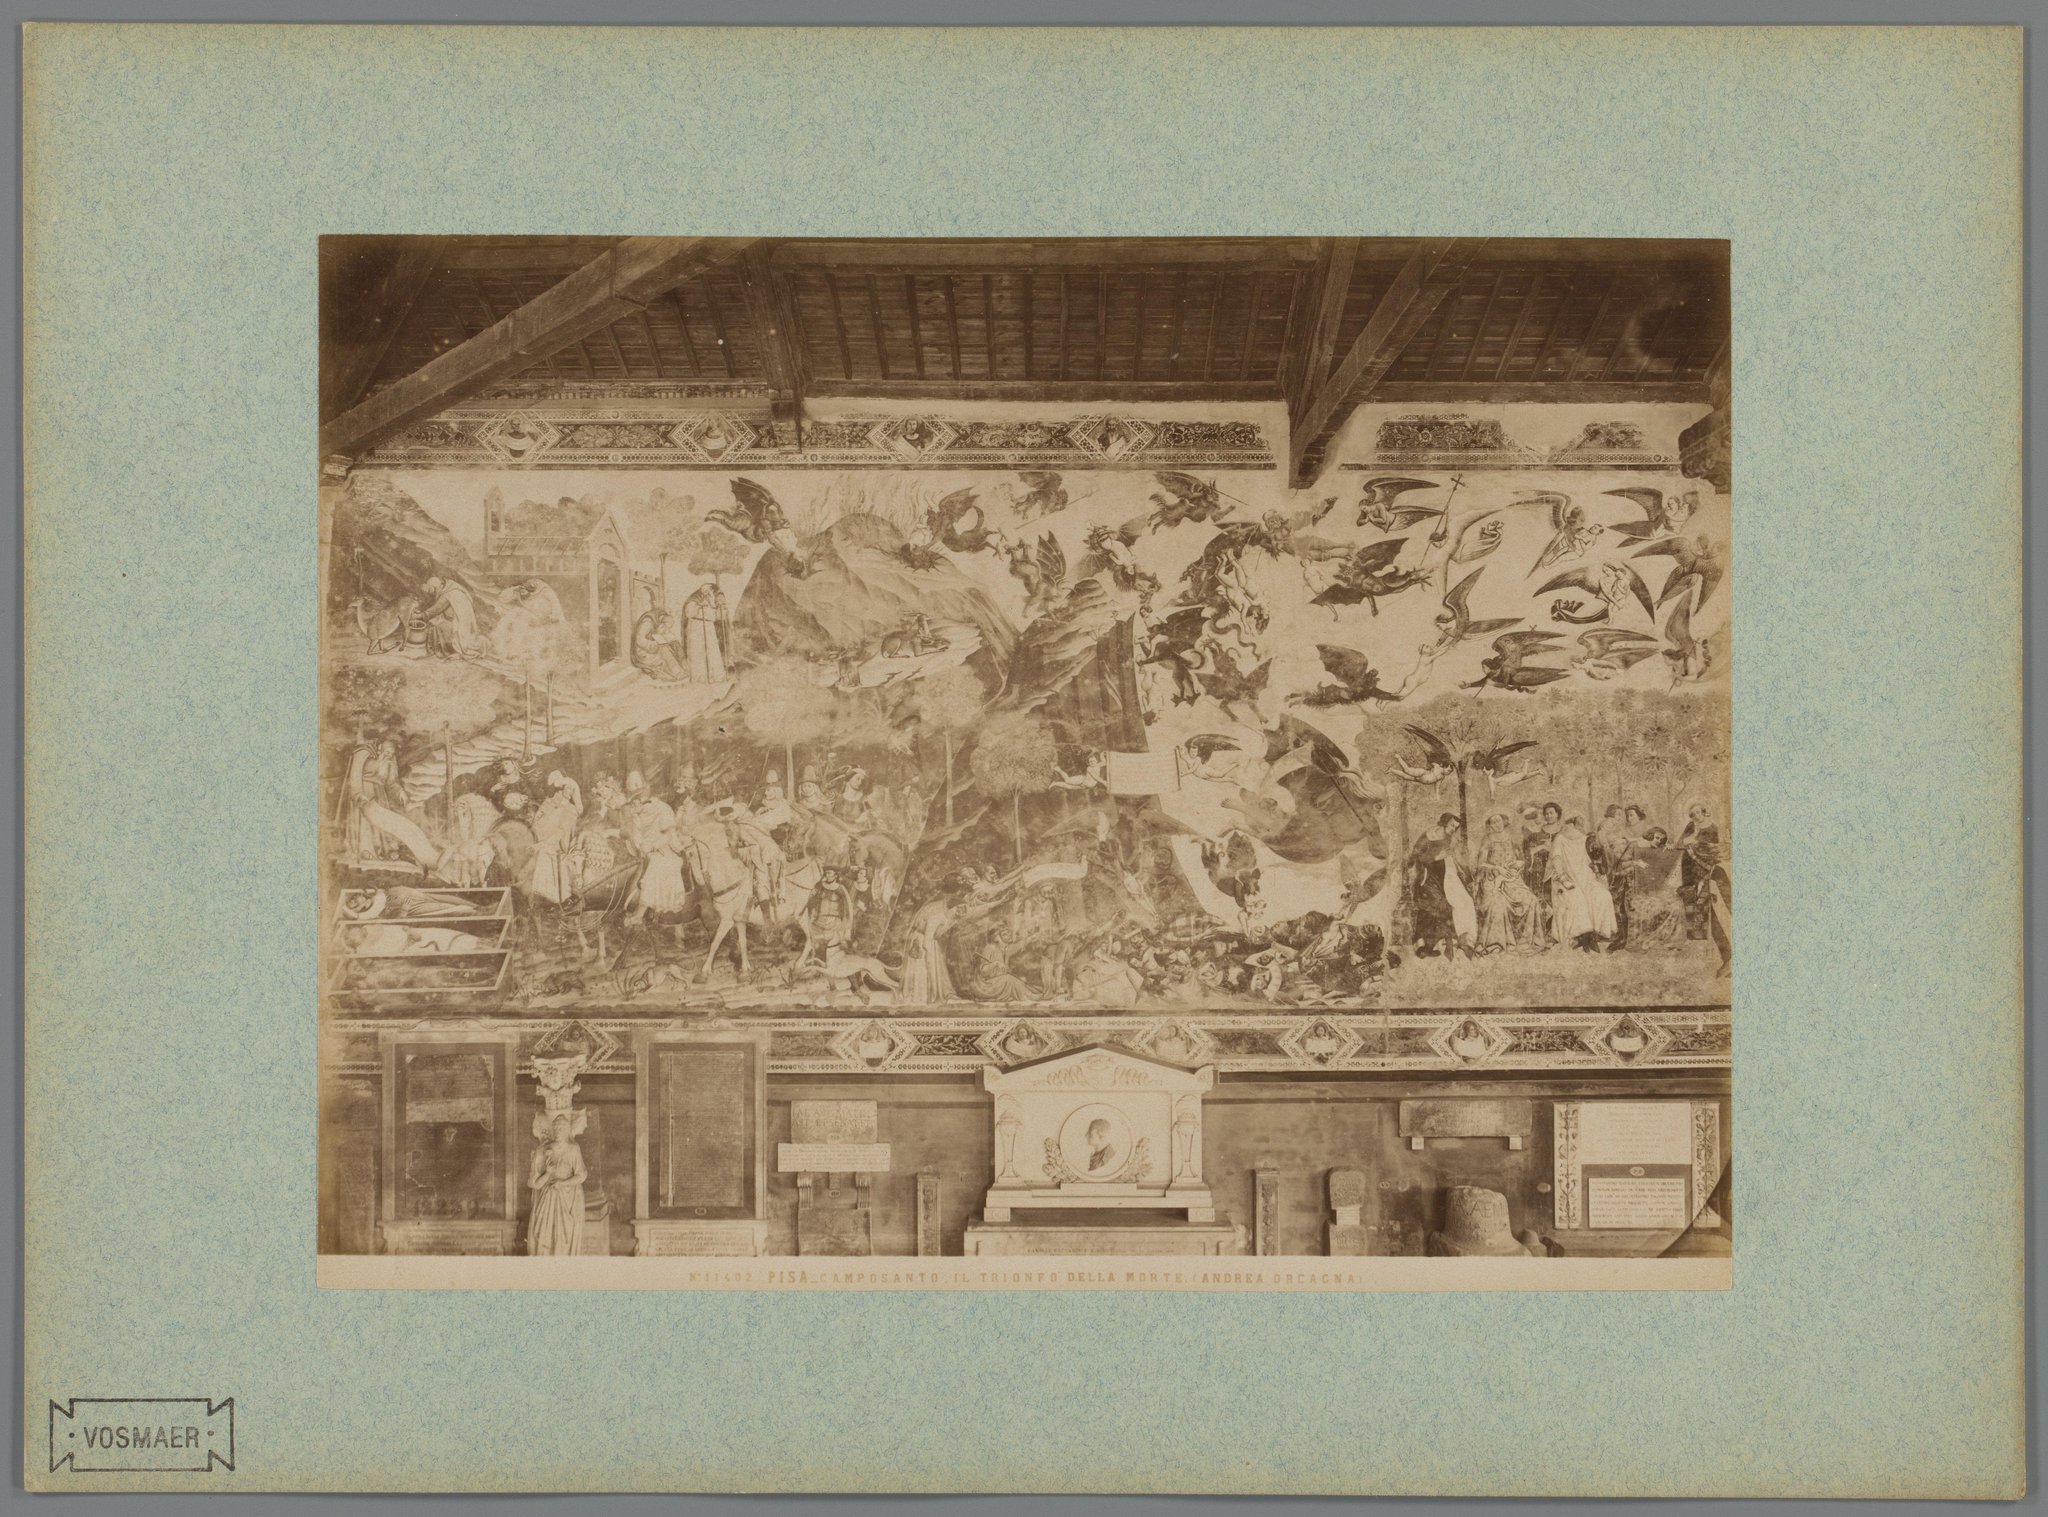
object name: photograph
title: Pisa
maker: andrea di cione named orcagna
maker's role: painter, sculptor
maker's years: 1320-1368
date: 1852-1900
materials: cardboard, paper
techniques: albumen print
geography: pisa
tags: wall-covering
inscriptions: collector's mark: ‘VOSMAER’, number: ‘No. 11402’